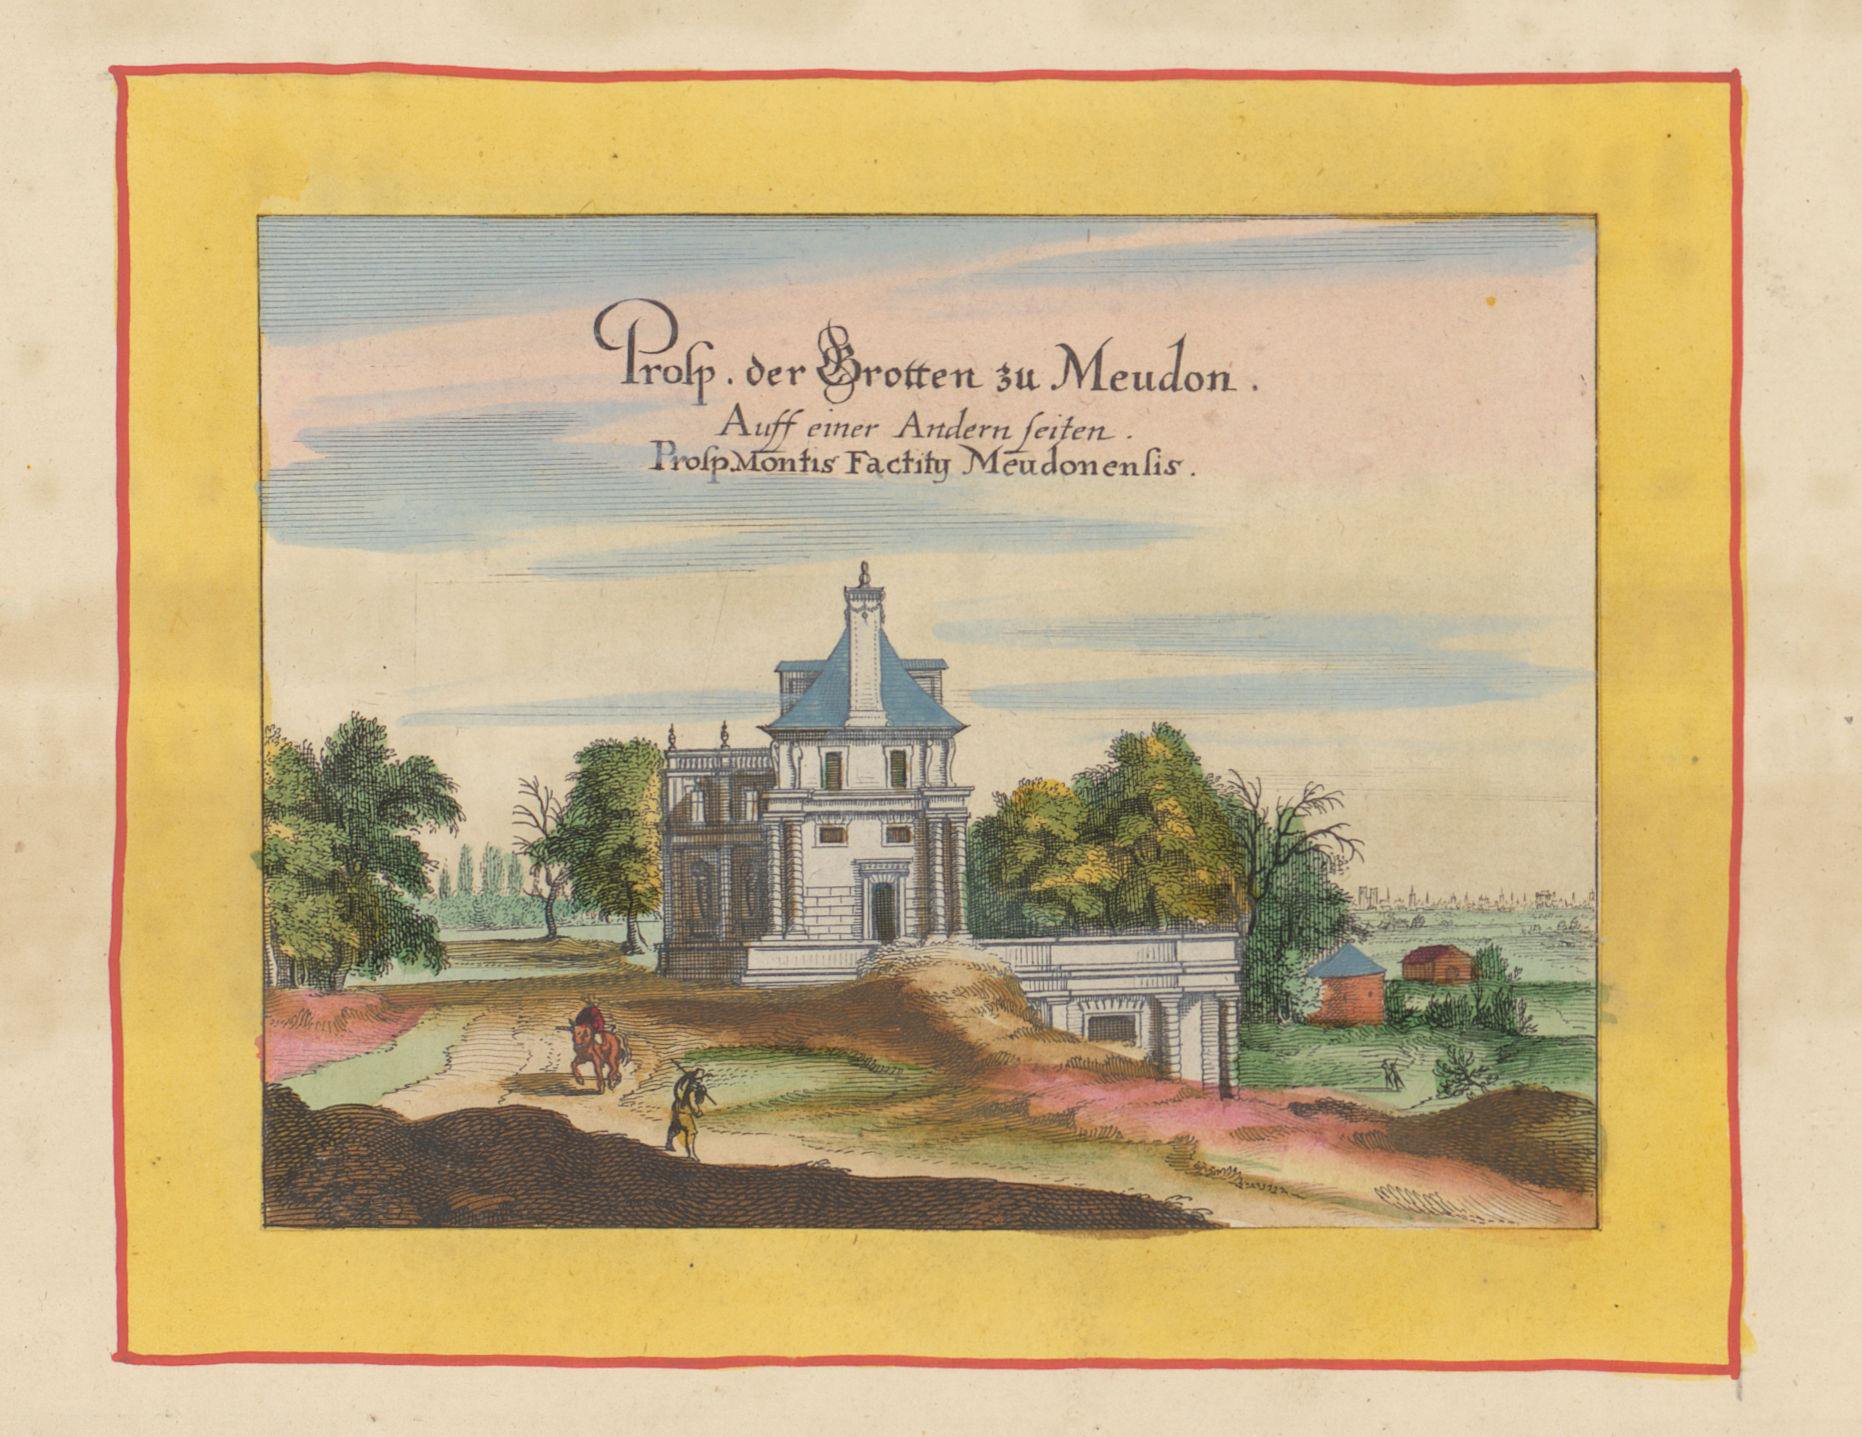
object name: print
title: Zijaanzicht van de zogenaamde Grot bij het kasteel van Meudon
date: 1655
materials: paper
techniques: engraving, etching, hand coloring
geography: frankfurt am main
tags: french or architectonic garden; formal garden, artificial grotto in garden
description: Prent origineel vervaardigd als boekillustratie voor: Zeiller, Martin. Topographia Galliae, oder Beschreibung und Contrafaitung der vornehmbsten und bekantisten Oerter in dem mächtigen und grossen Königreich Frankreich, 13 delen. Frankfurt am Main: Caspar Merian, 1655-1661. De prent werd voor het eerst gepubliceerd in deel 1: Topographia Galliae, 1655.